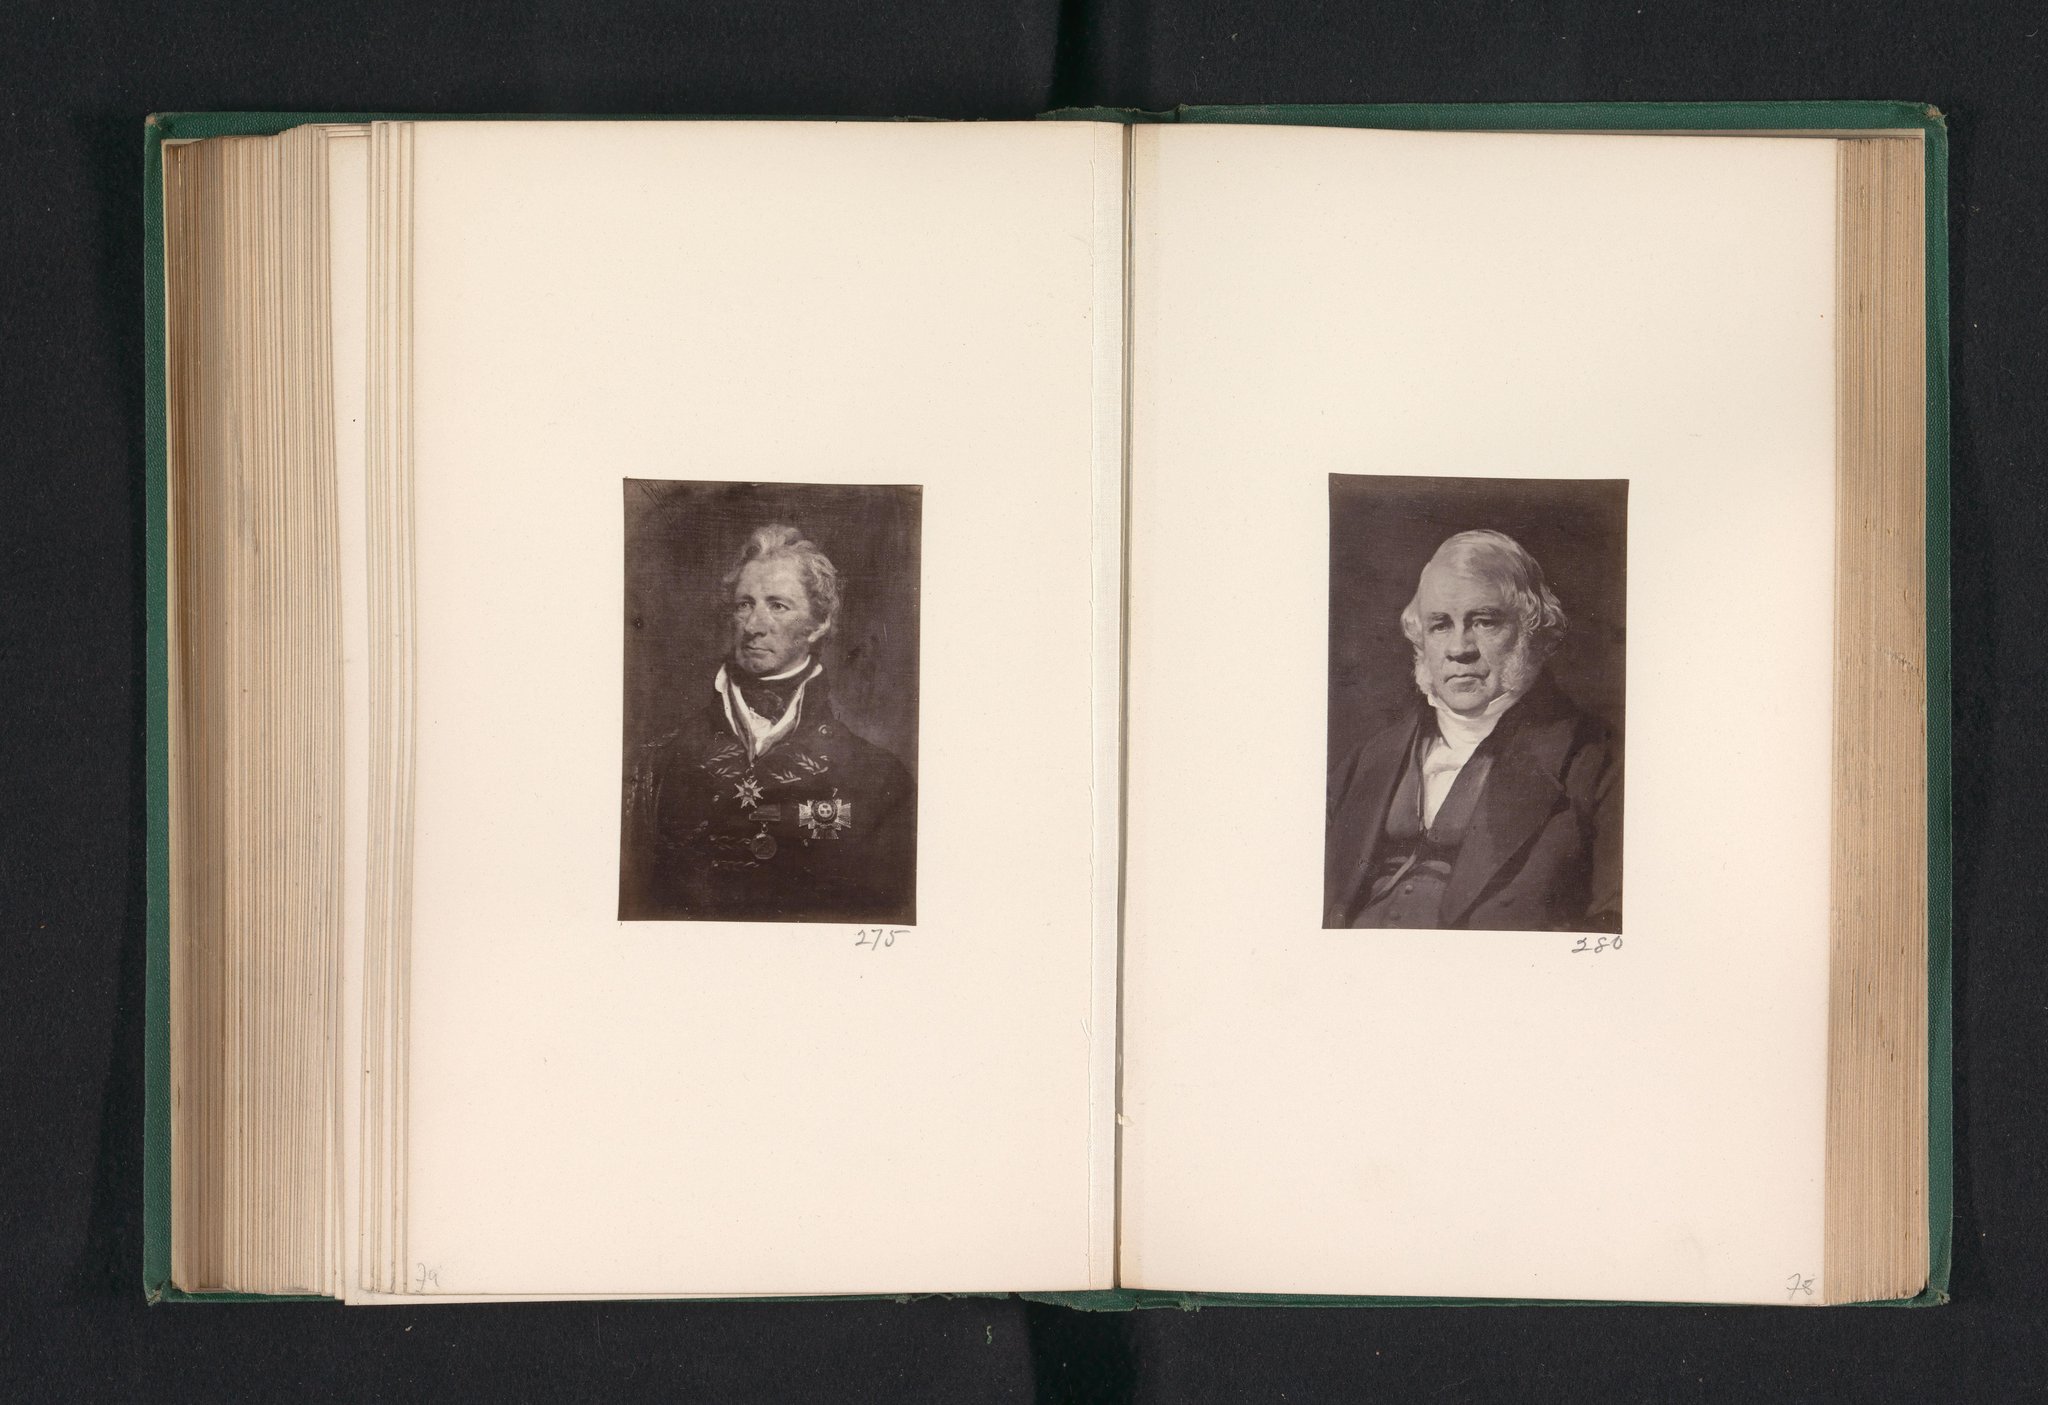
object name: page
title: Fotoreproductie van een schilderij, voorstellende een portret van James Richardson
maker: thomas annan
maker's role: fotograaf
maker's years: 1829-1887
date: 1863-1868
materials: photographic support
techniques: albumen print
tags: historical persons (portraits and scenes from the life) (+ (full) bust portrait)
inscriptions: number: ‘280’